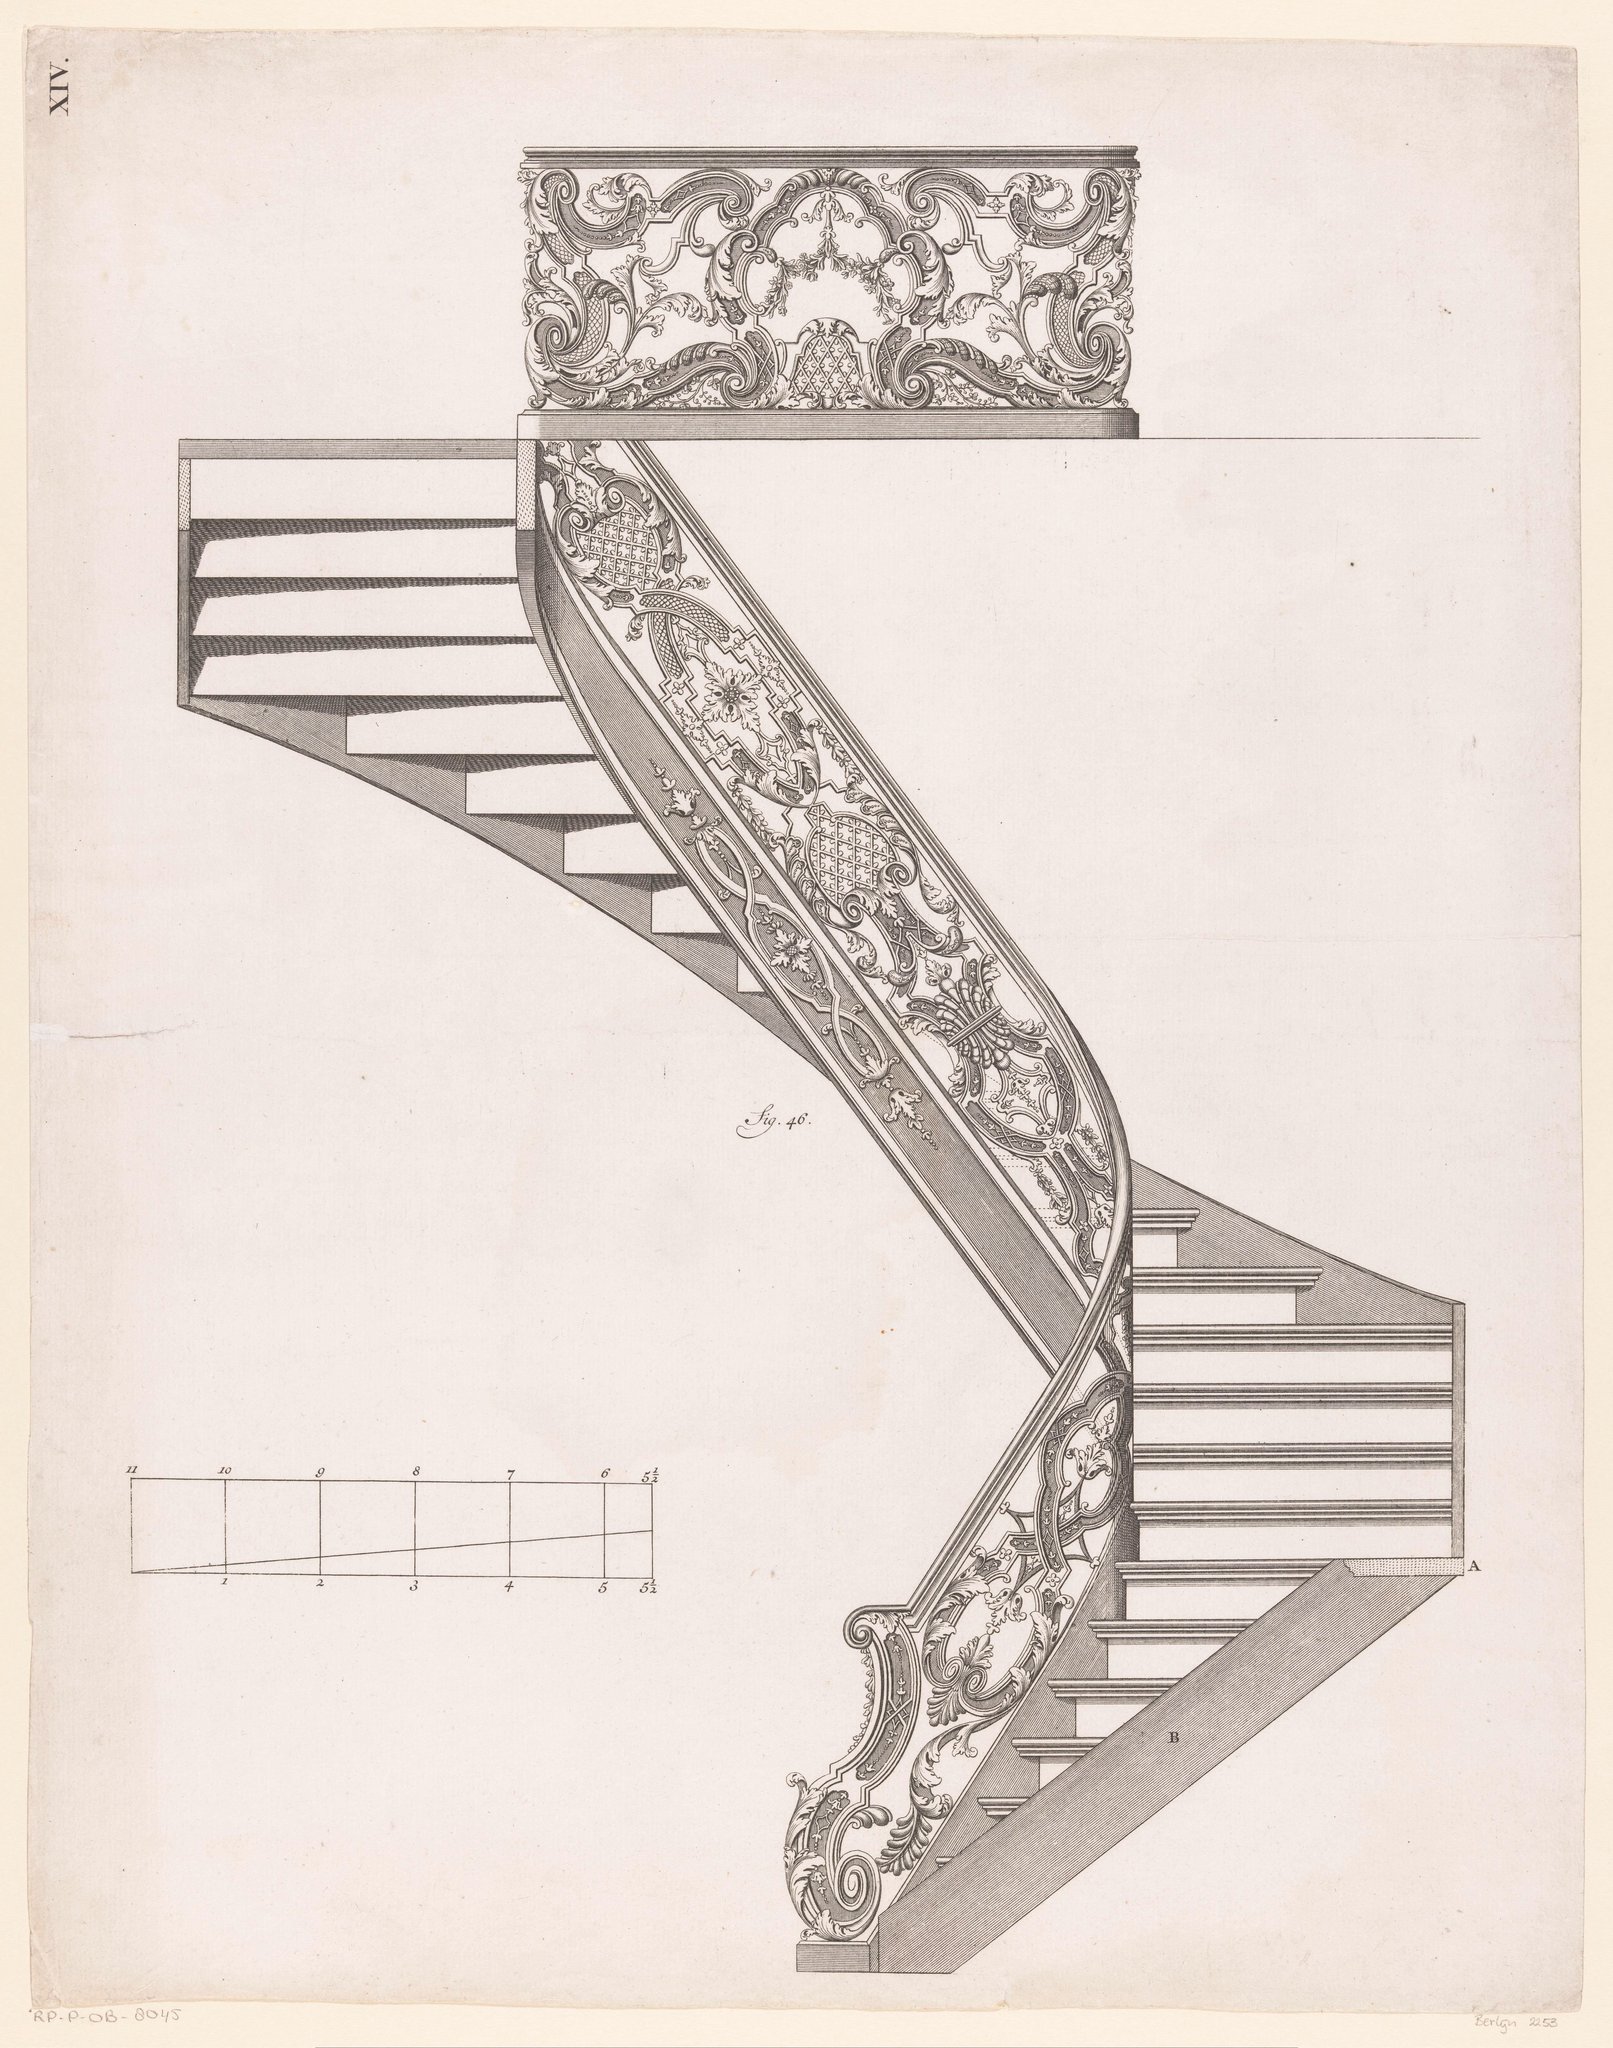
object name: print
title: Theatrum Machinarum Universale; Of Nieuwe Algemeende Bouwkunde (...)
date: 1739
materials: paper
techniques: engraving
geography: amsterdam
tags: drawing (mathematics), staircase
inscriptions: collector's mark: Lugt 2228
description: Technische tekeningen van een wenteltrap (nummer 46). Zijaanzicht.